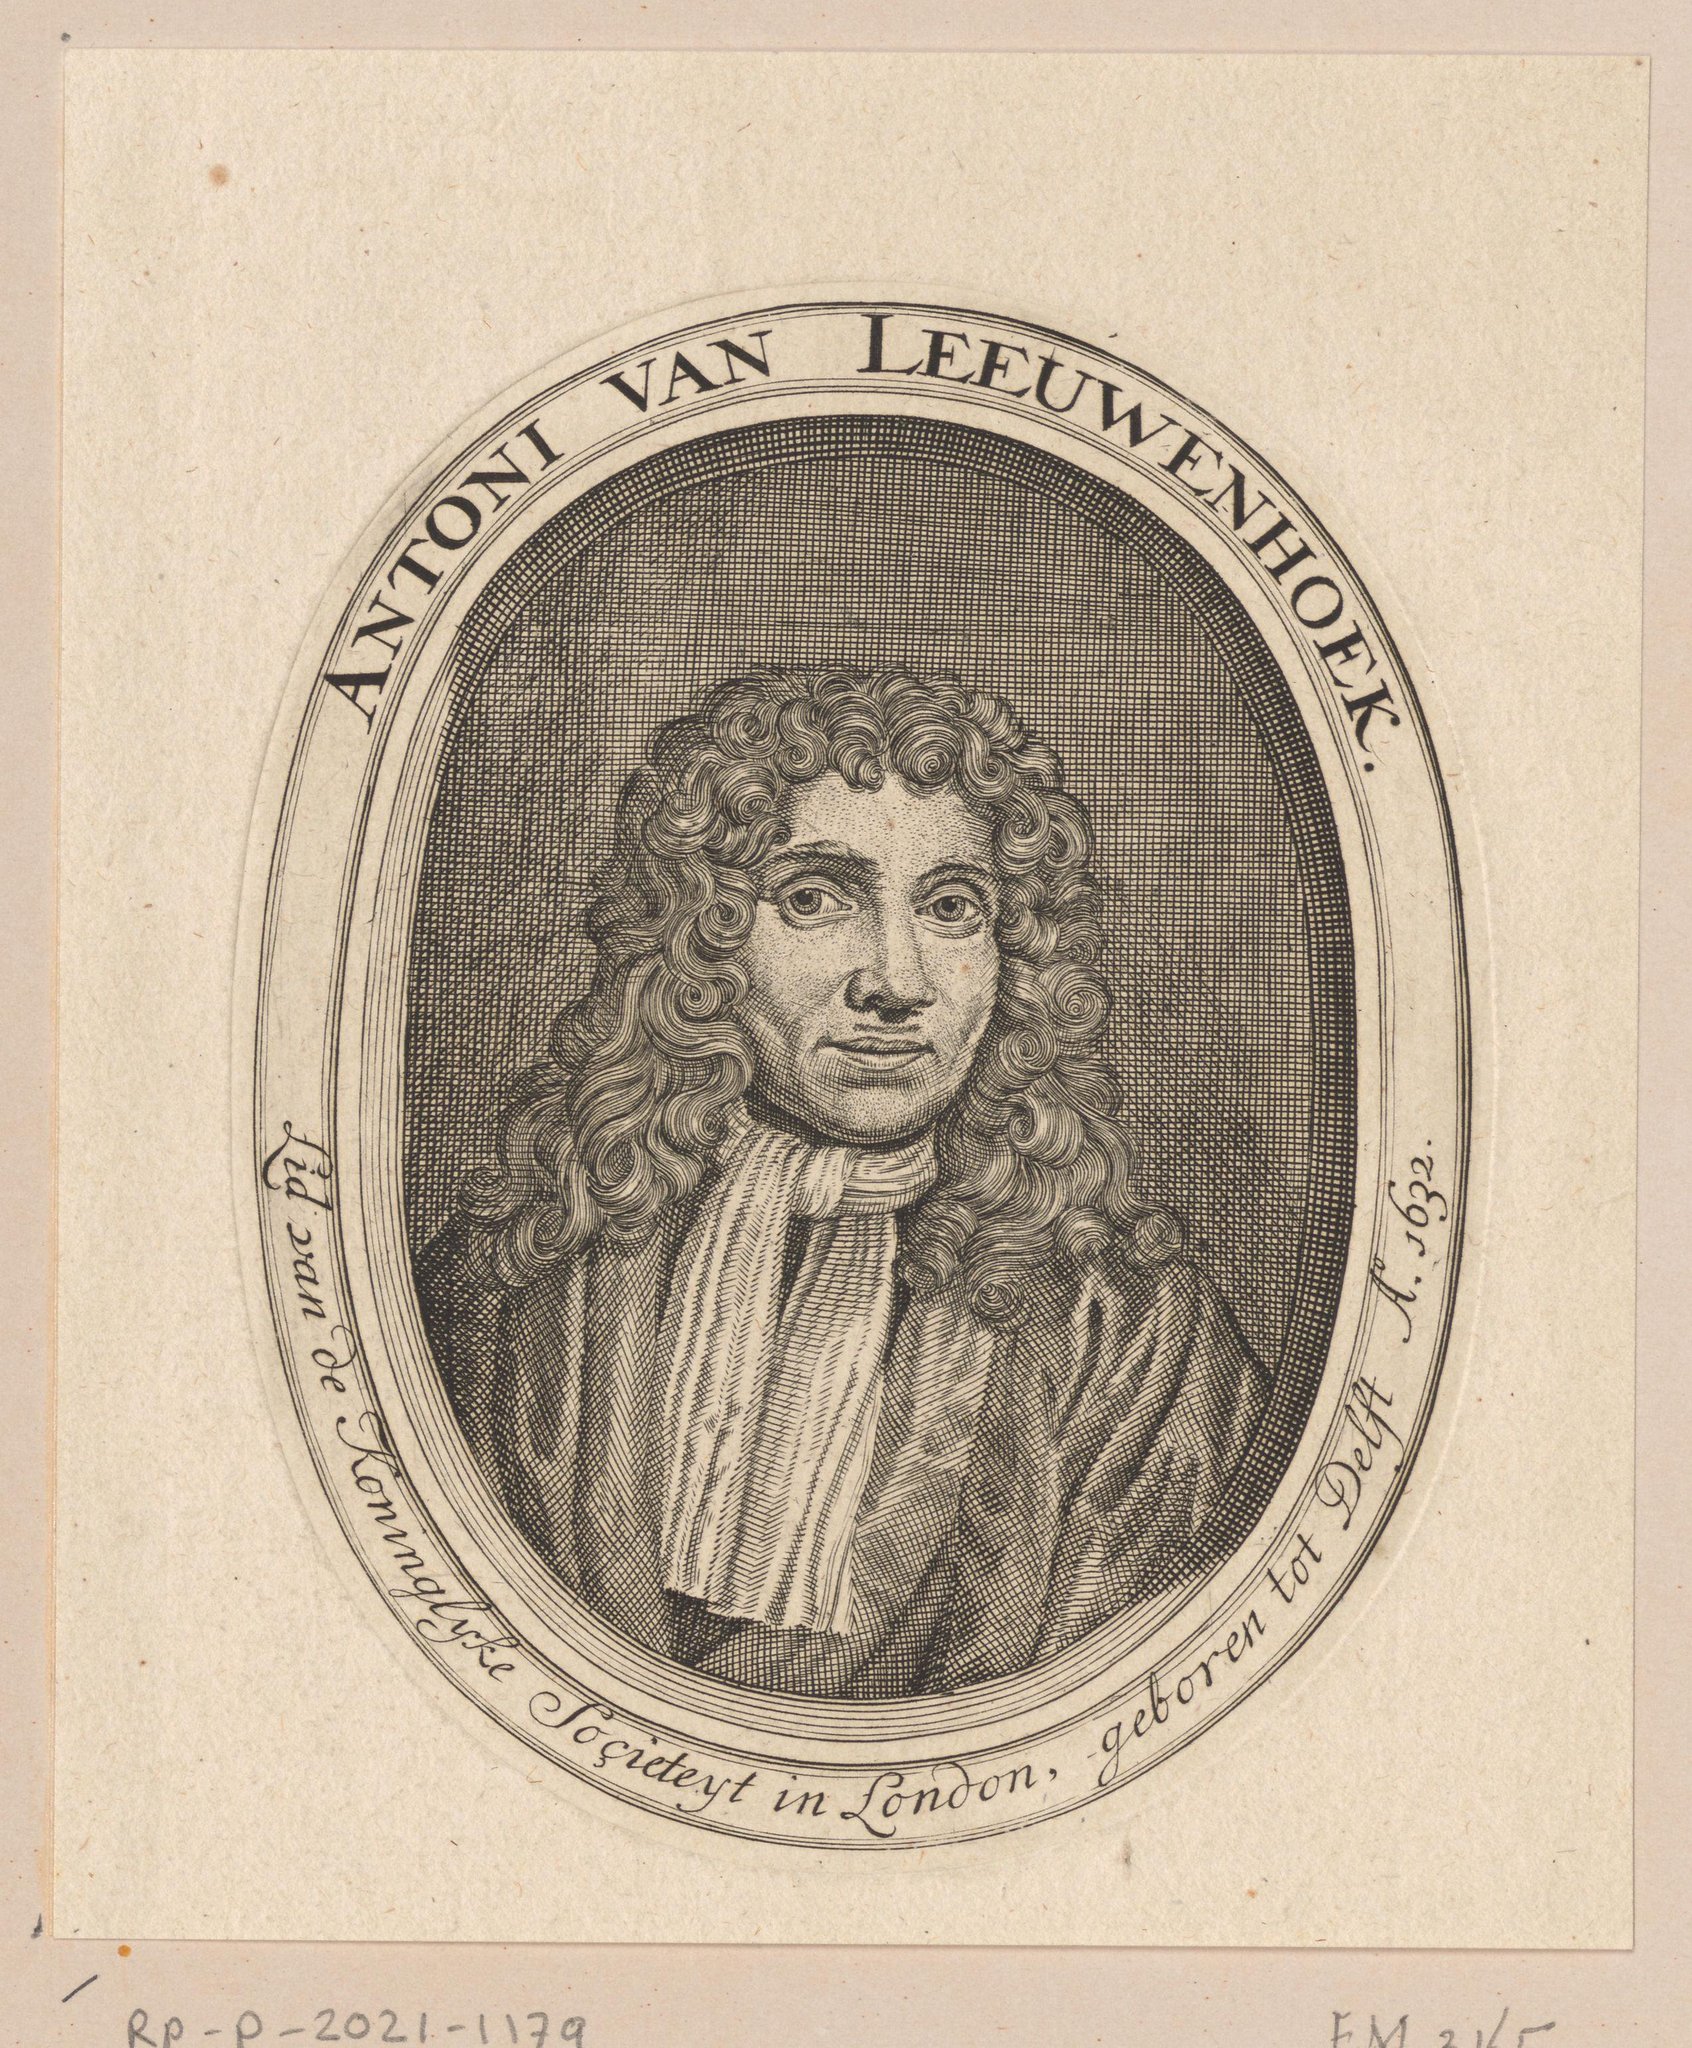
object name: print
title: Portret van Anthony van Leeuwenhoek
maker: Anonymous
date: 1680-1723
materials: paper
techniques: engraving, etching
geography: northern netherlands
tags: delft, physicist, anthony van leeuwenhoek, ornament ~ medallion, historical persons, science and technology (+ portrait of scholar, scientist)